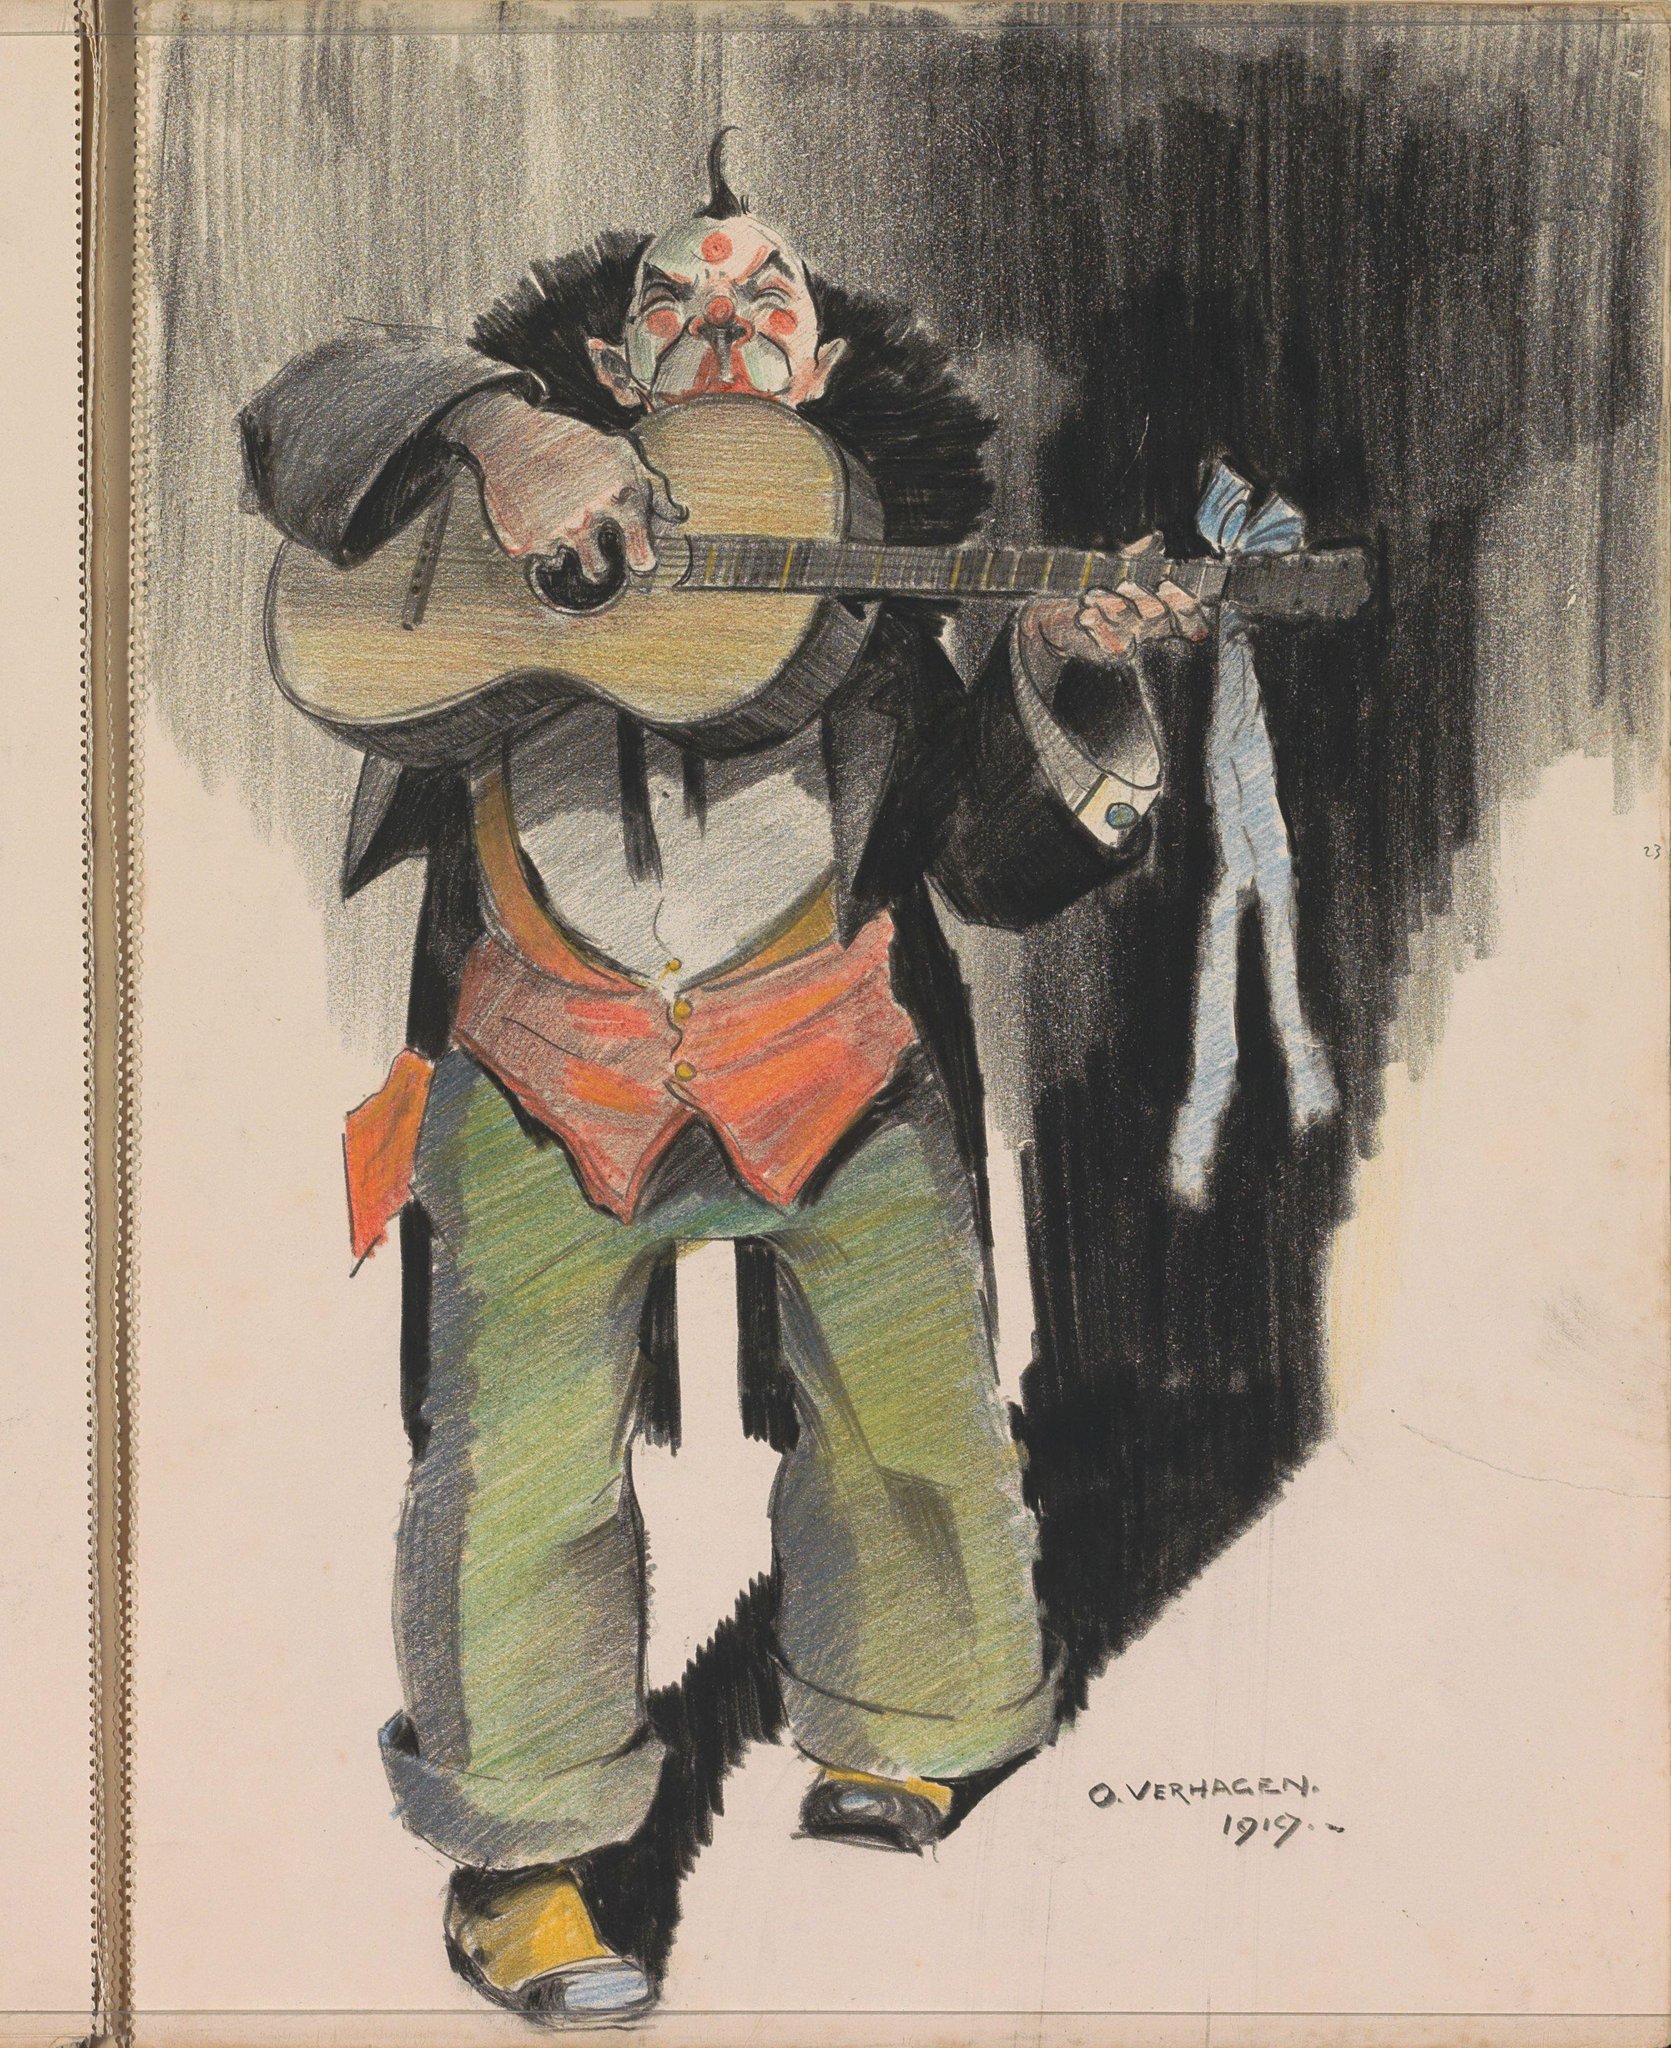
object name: sketchbook leaf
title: Geschminkte gitaarspelende man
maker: otto verhagen (i)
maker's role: draughtsman, print maker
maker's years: 1885-1951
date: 1919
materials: chalk, paper, pencil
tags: cithern, mandolin, guitar, balalaika (+ artist at work), stage costume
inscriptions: signature and date: ‘O.Verhagen./ 1919.-’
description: De man draagt een kostuum, onder andere bestaande uit een lange jas afgezet met een bontkraag. Pagina 23 uit een schetsboek met 28 bladen.